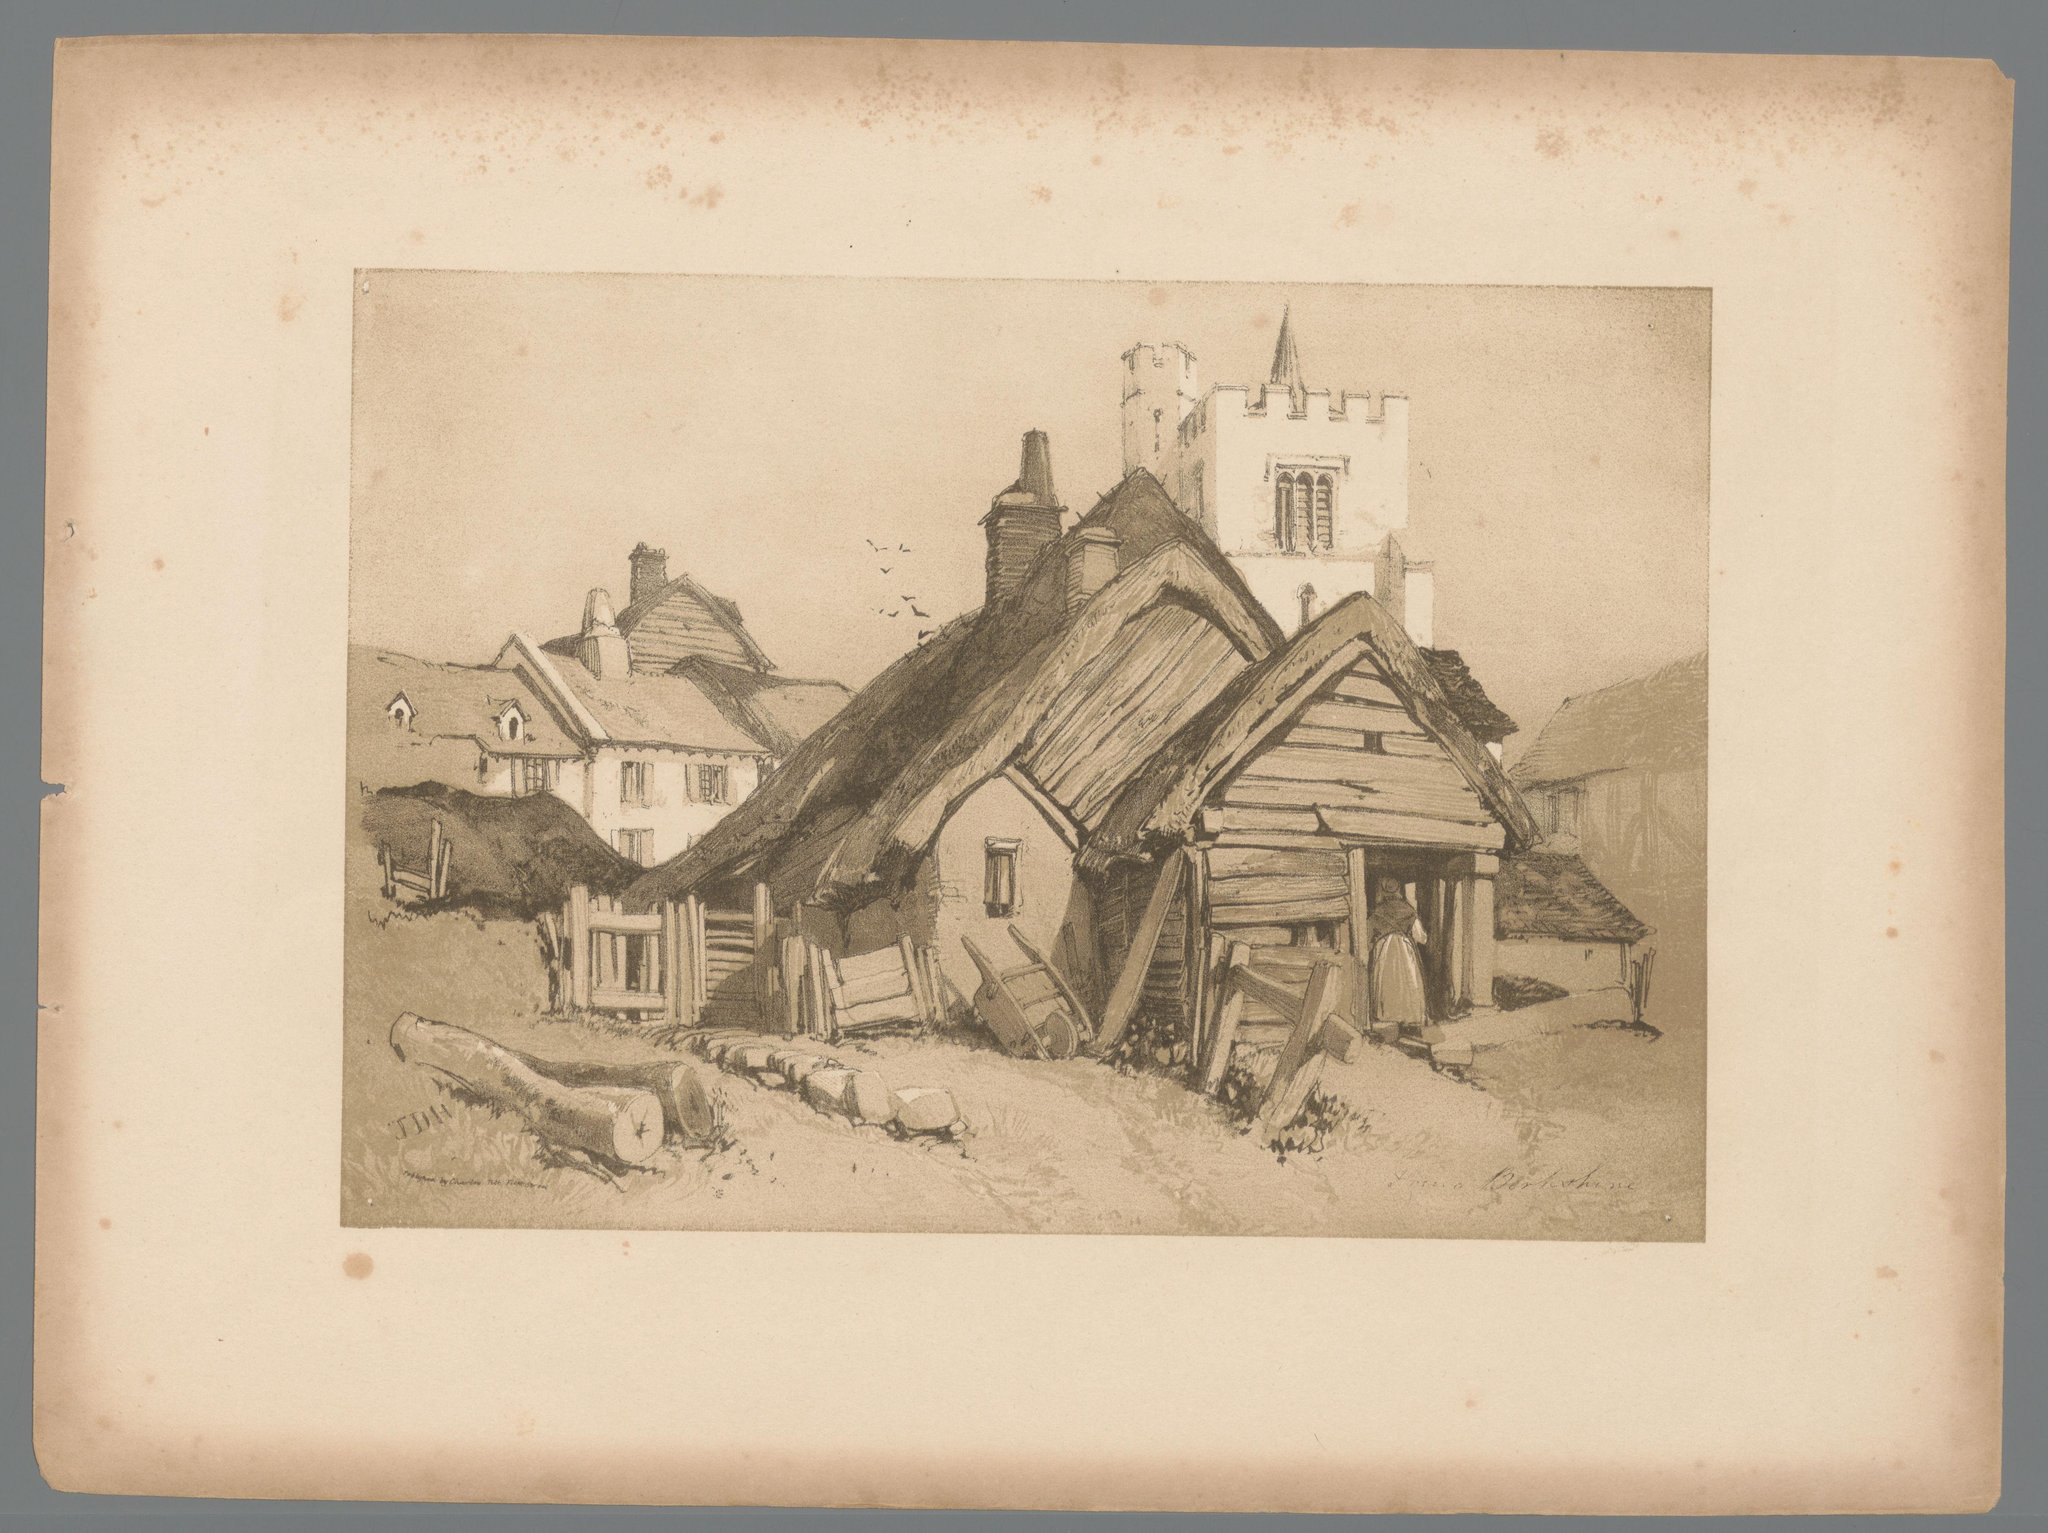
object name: print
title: Tekenboek met werken van James Duffield Harding 1841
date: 1841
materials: paper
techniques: tone lithography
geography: london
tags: village (+ city(-scape) with figures, staffage), civic architecture; edifices; dwellings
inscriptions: collector's mark: Lugt 2228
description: Uitgever Charles Tilt (met Bogue) heeft verschillende series uitgegeven over het werk van James Duffield Harding. Deze serie 'Harding's drawing book, for the year MDCCCXLI', bestaat uit zes delen.